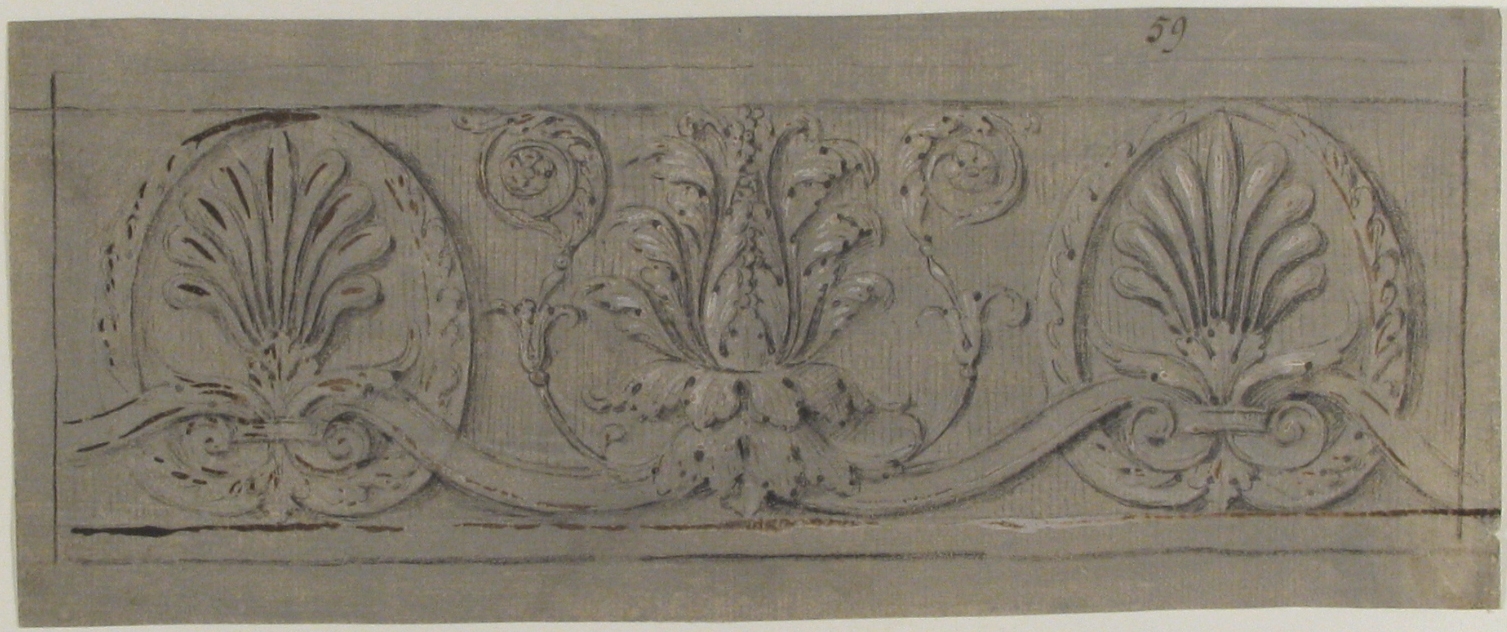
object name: drawing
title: Design for a Decorative Frieze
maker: anonymous, french, 19th century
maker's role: artist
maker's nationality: french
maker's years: 1800-1900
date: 1825-1850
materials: chalk, graphite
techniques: brush, heightening, wash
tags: ornament